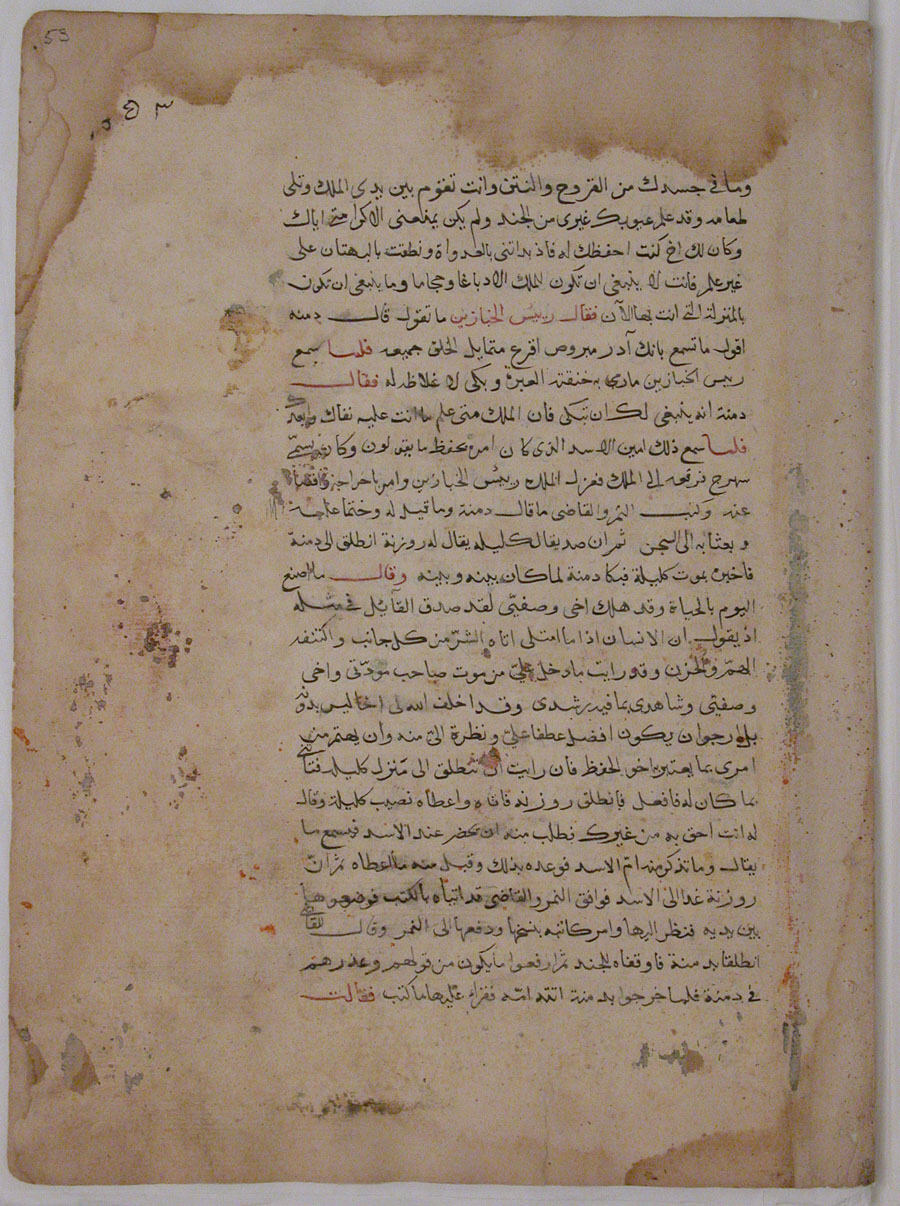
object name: folio from an illustrated manuscript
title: Page of Calligraphy from a Kalila wa Dimna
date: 1526-1550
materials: ink, paper, watercolor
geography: india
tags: arabic,calligraphy